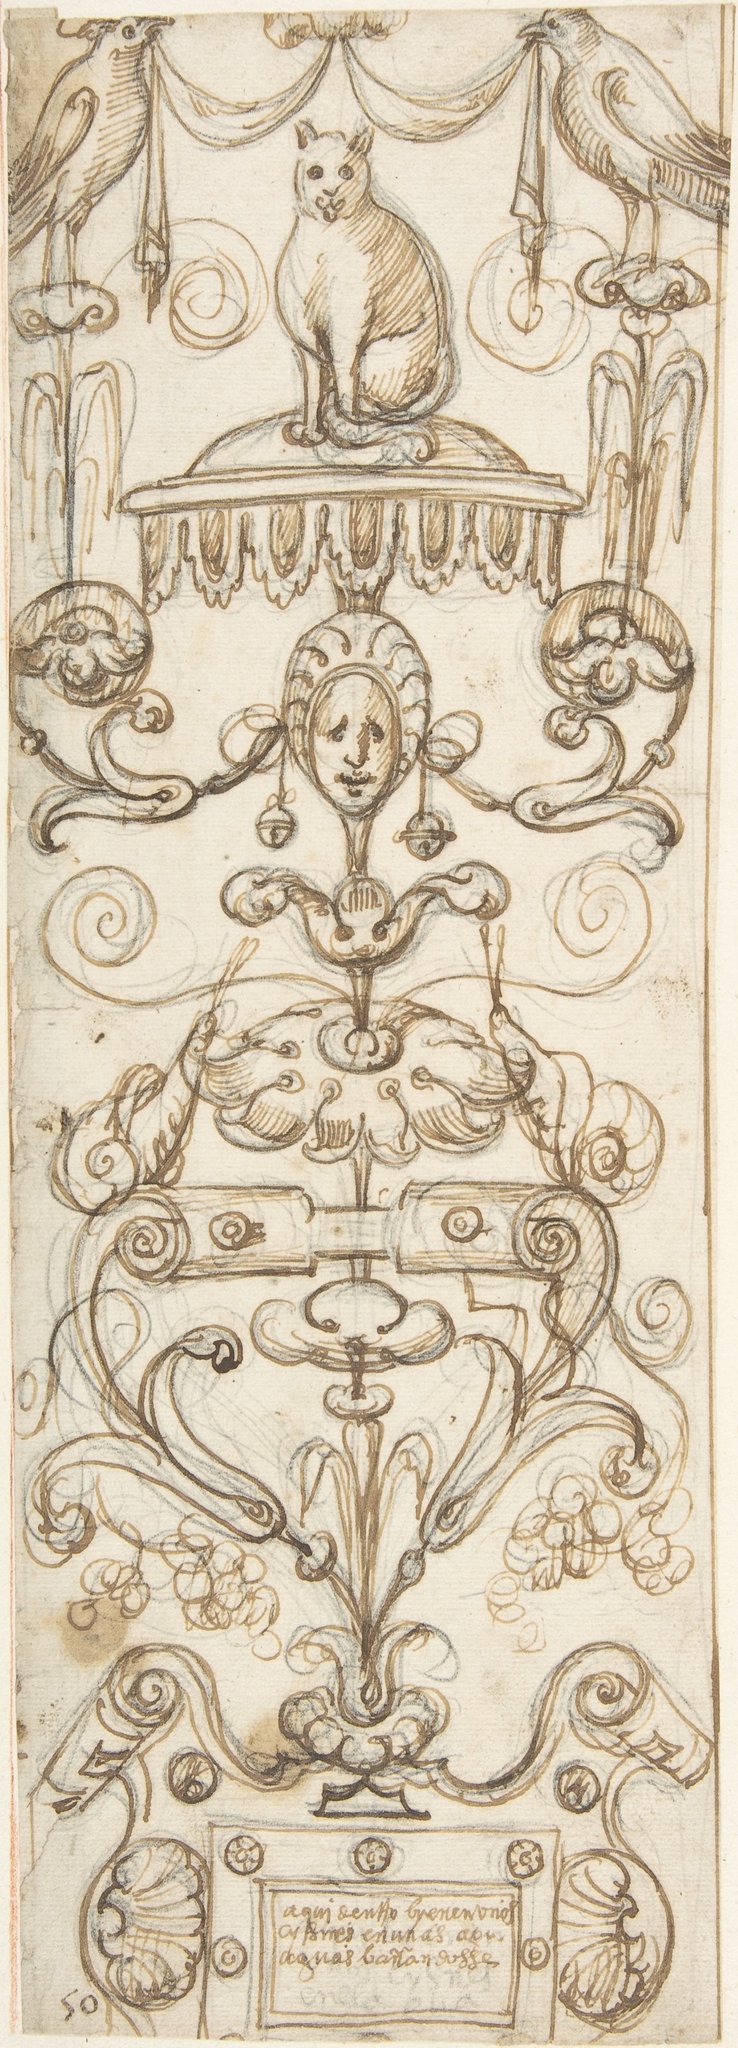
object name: drawing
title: Candelabra Grotesque with a Cat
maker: andrés de melgar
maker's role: artist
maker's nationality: spanish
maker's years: 1554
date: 1545-1560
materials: chalk, ink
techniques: pen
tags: grotesques,ornament,cats